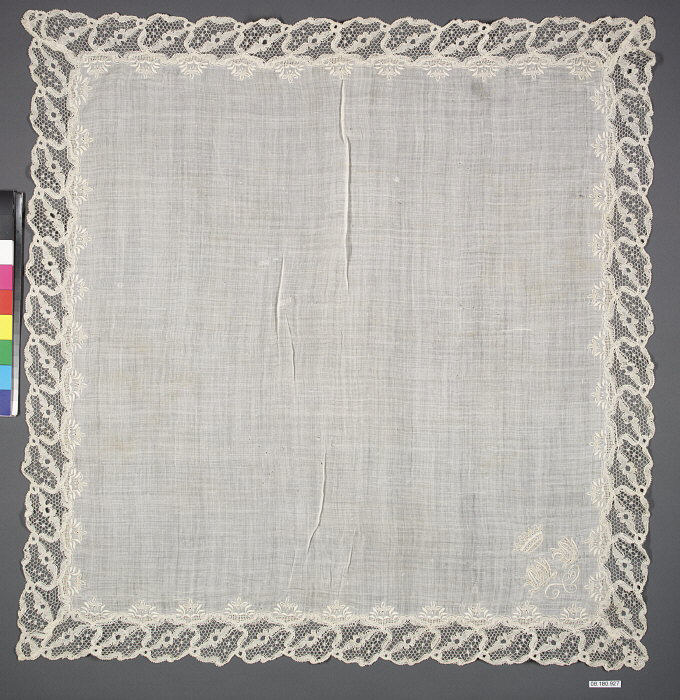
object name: handkerchief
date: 1801-1900